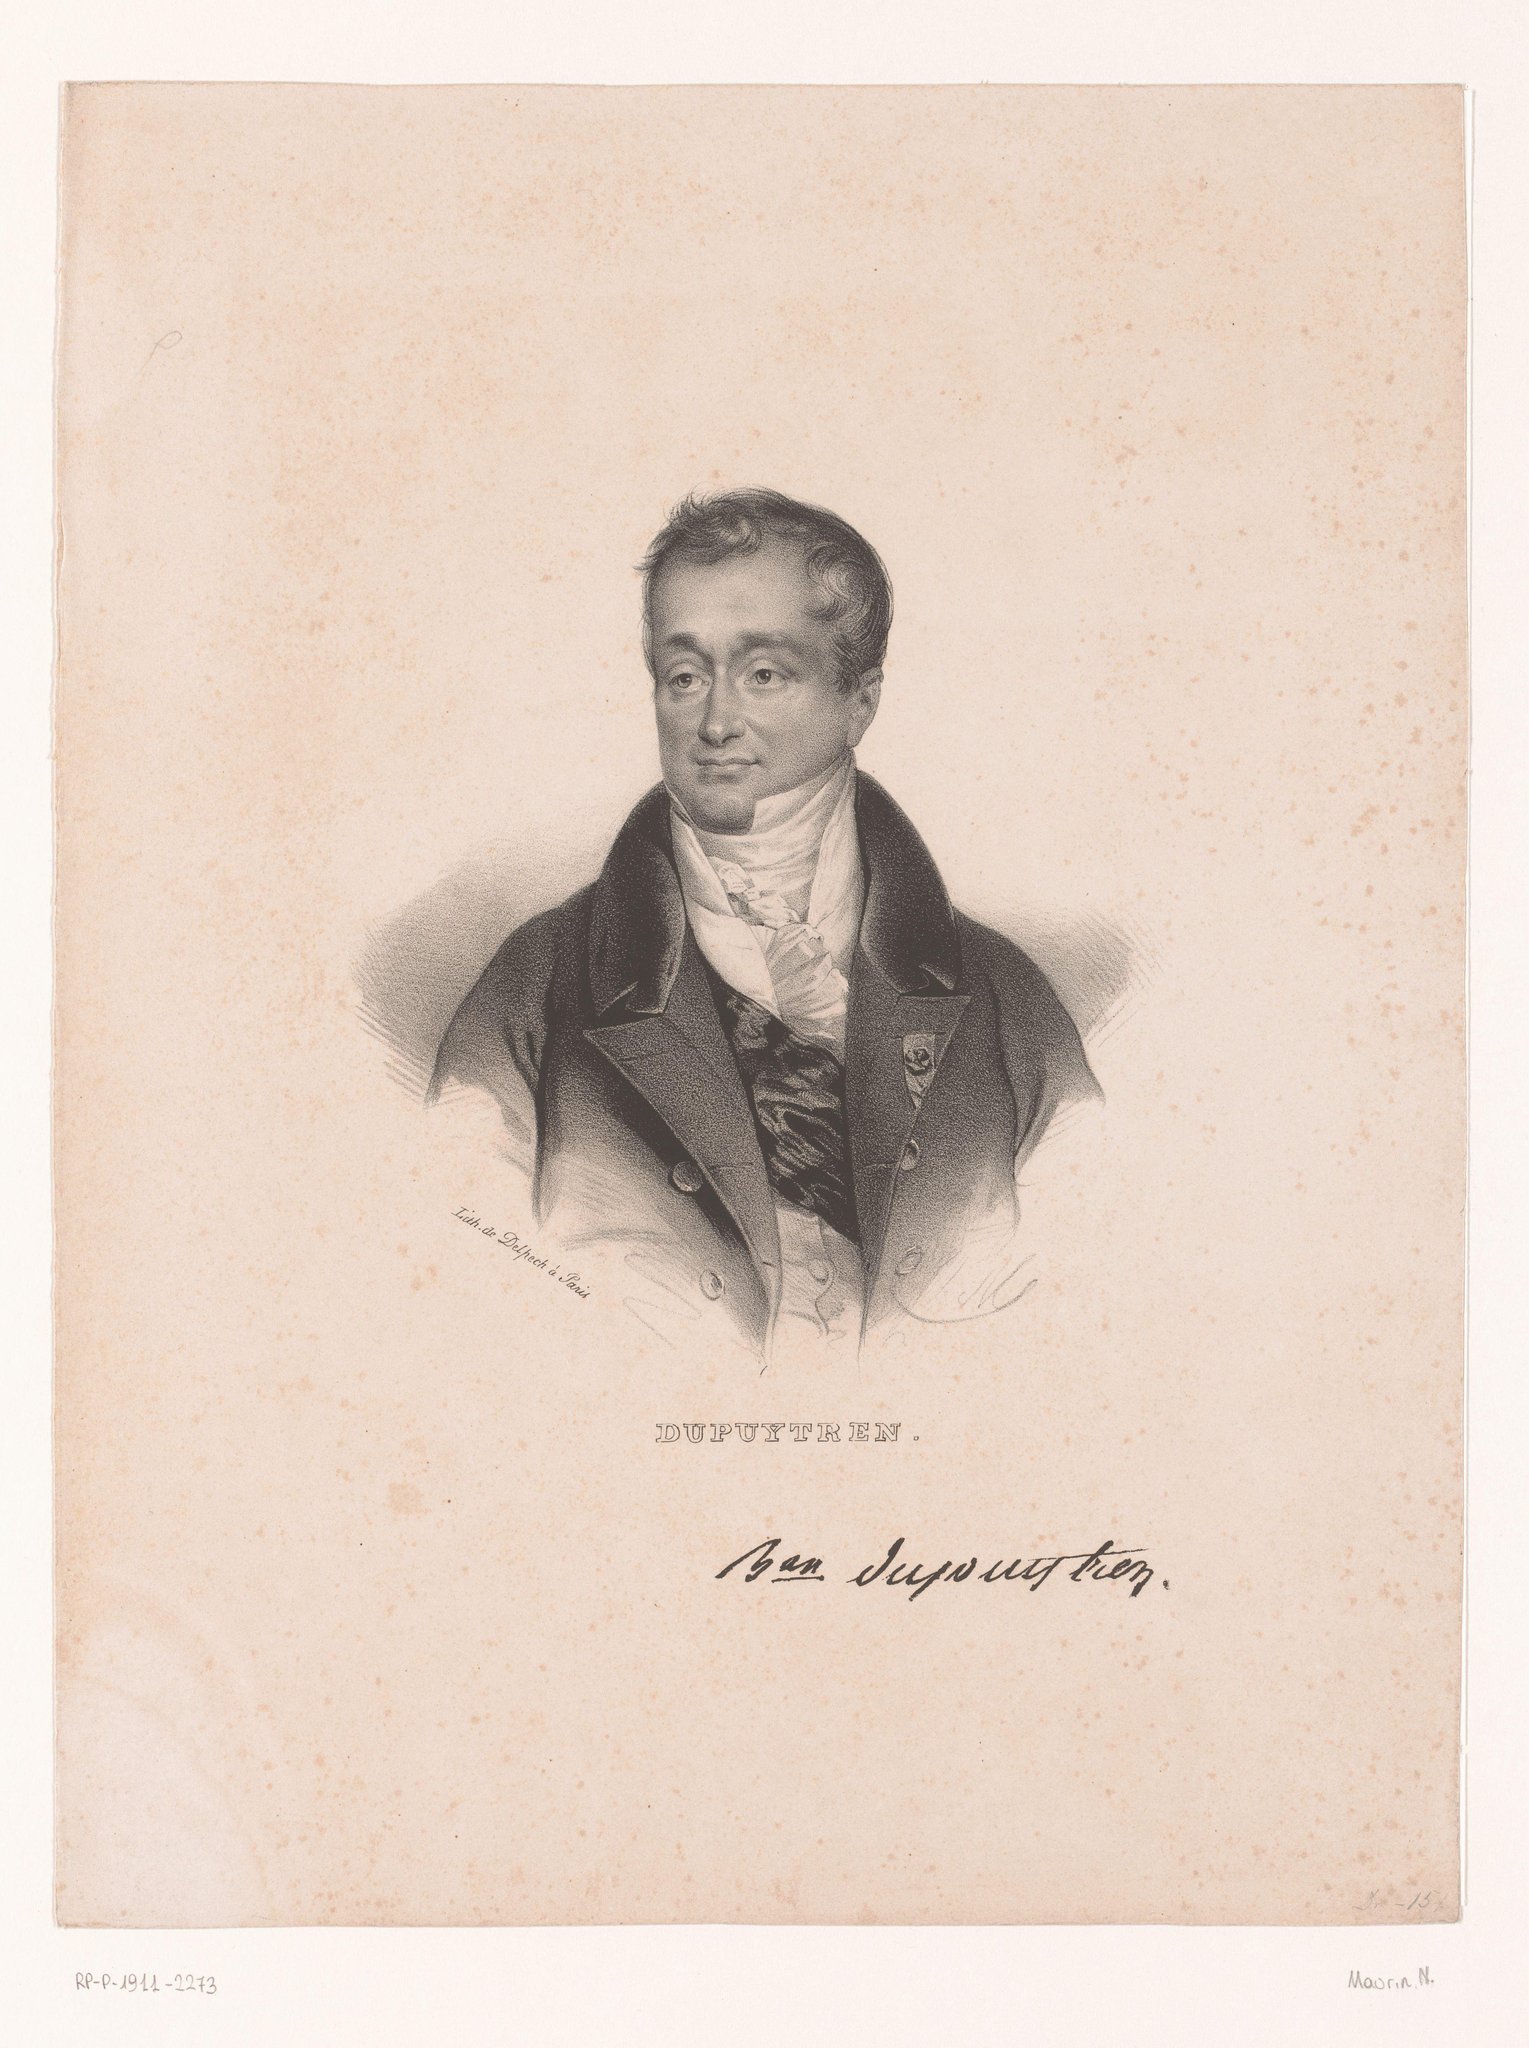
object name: print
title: Dupuytren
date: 1825-1842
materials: paper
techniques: lithograph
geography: paris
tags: historical persons, physician, doctor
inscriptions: collector's mark: Lugt 2228